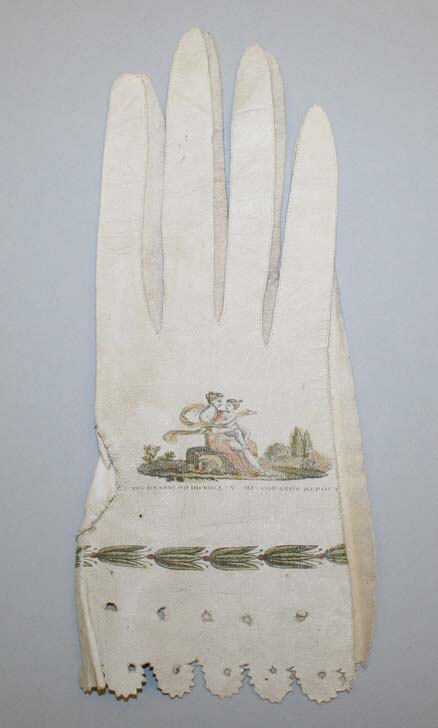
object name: glove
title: Gloves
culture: spanish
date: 1801-1833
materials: leather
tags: children,women